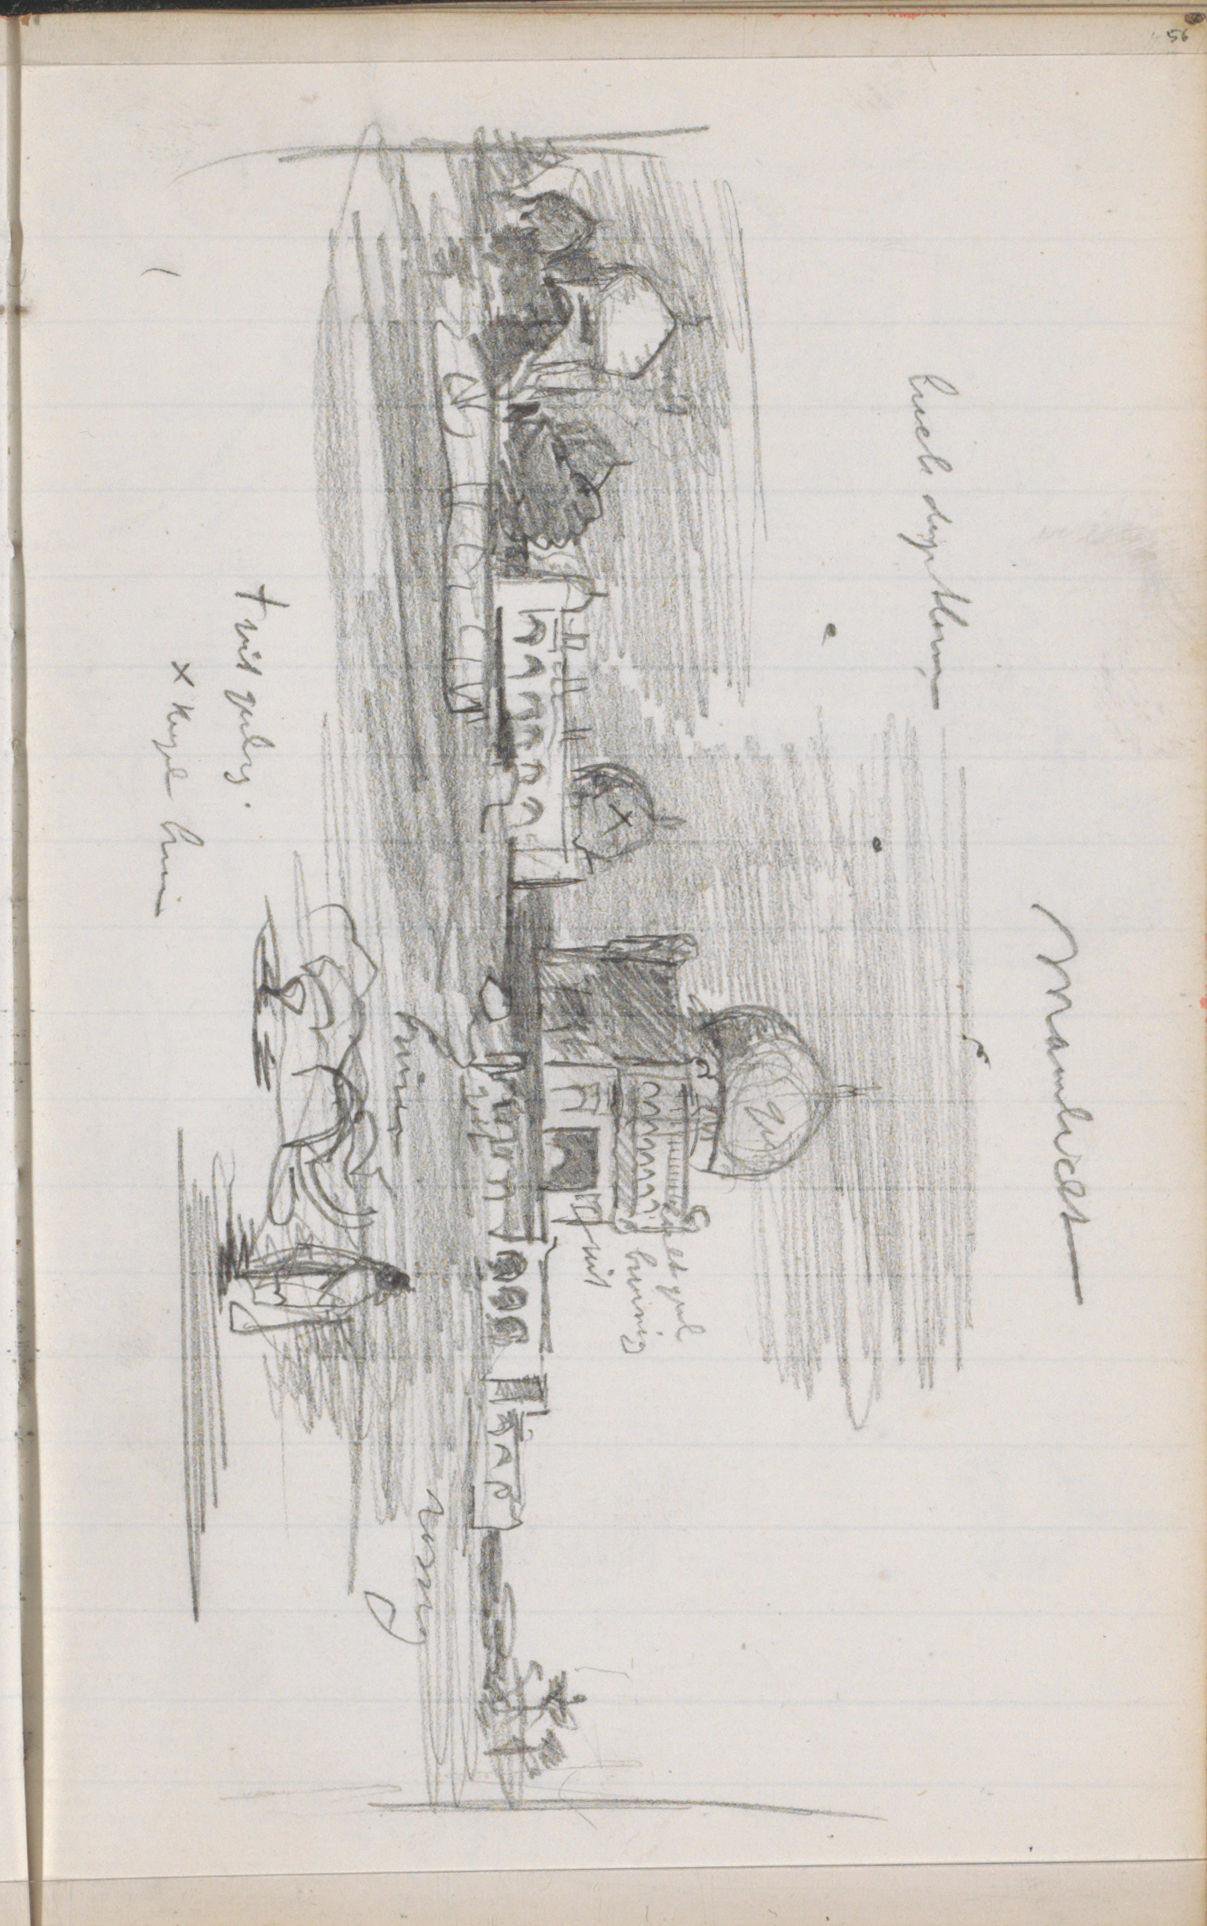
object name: sketchbook leaf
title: Landschap met een gebouw met een koepel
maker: marius bauer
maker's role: draughtsman, print maker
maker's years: 1867-1932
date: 1897-1898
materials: pencil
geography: india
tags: landscapes, architecture, dome ~ architecture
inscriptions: annotation: ‘Mamhcet’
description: Mogelijk is het gebouw een tempel of ander religieus bouwwerk. Pagina 56 uit een schetsboek met 62 bladen.